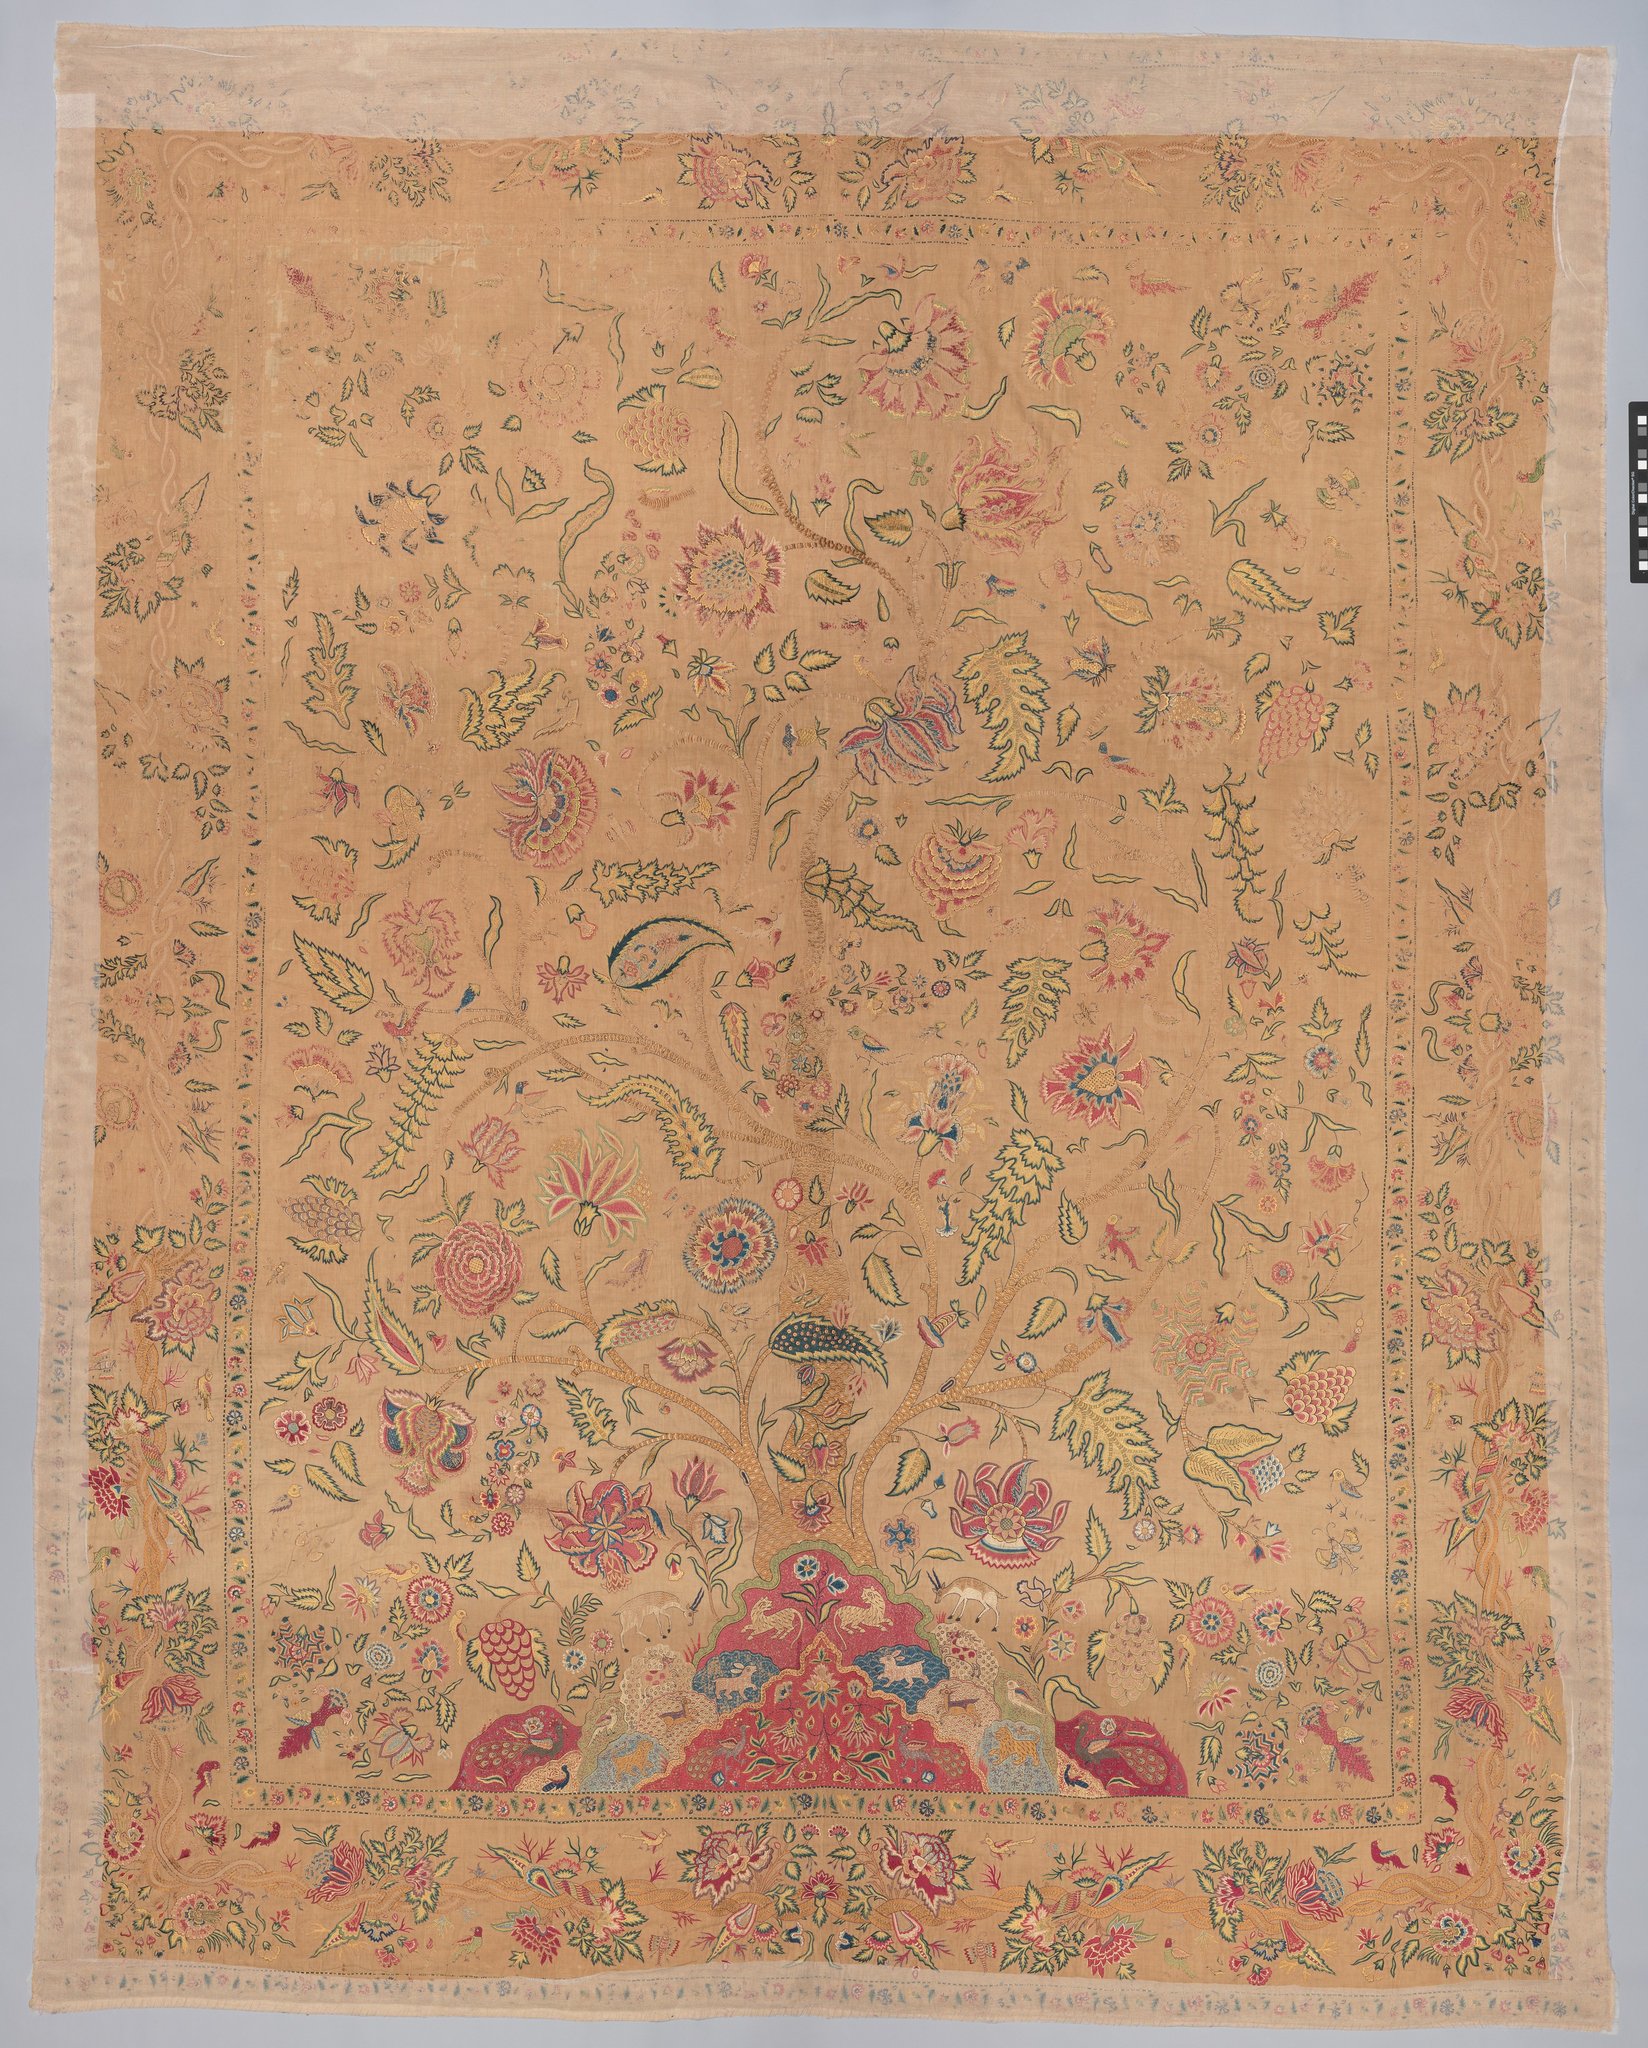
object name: hanging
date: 1734-1766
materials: cotton, silk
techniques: embroidery, weave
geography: india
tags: flowers